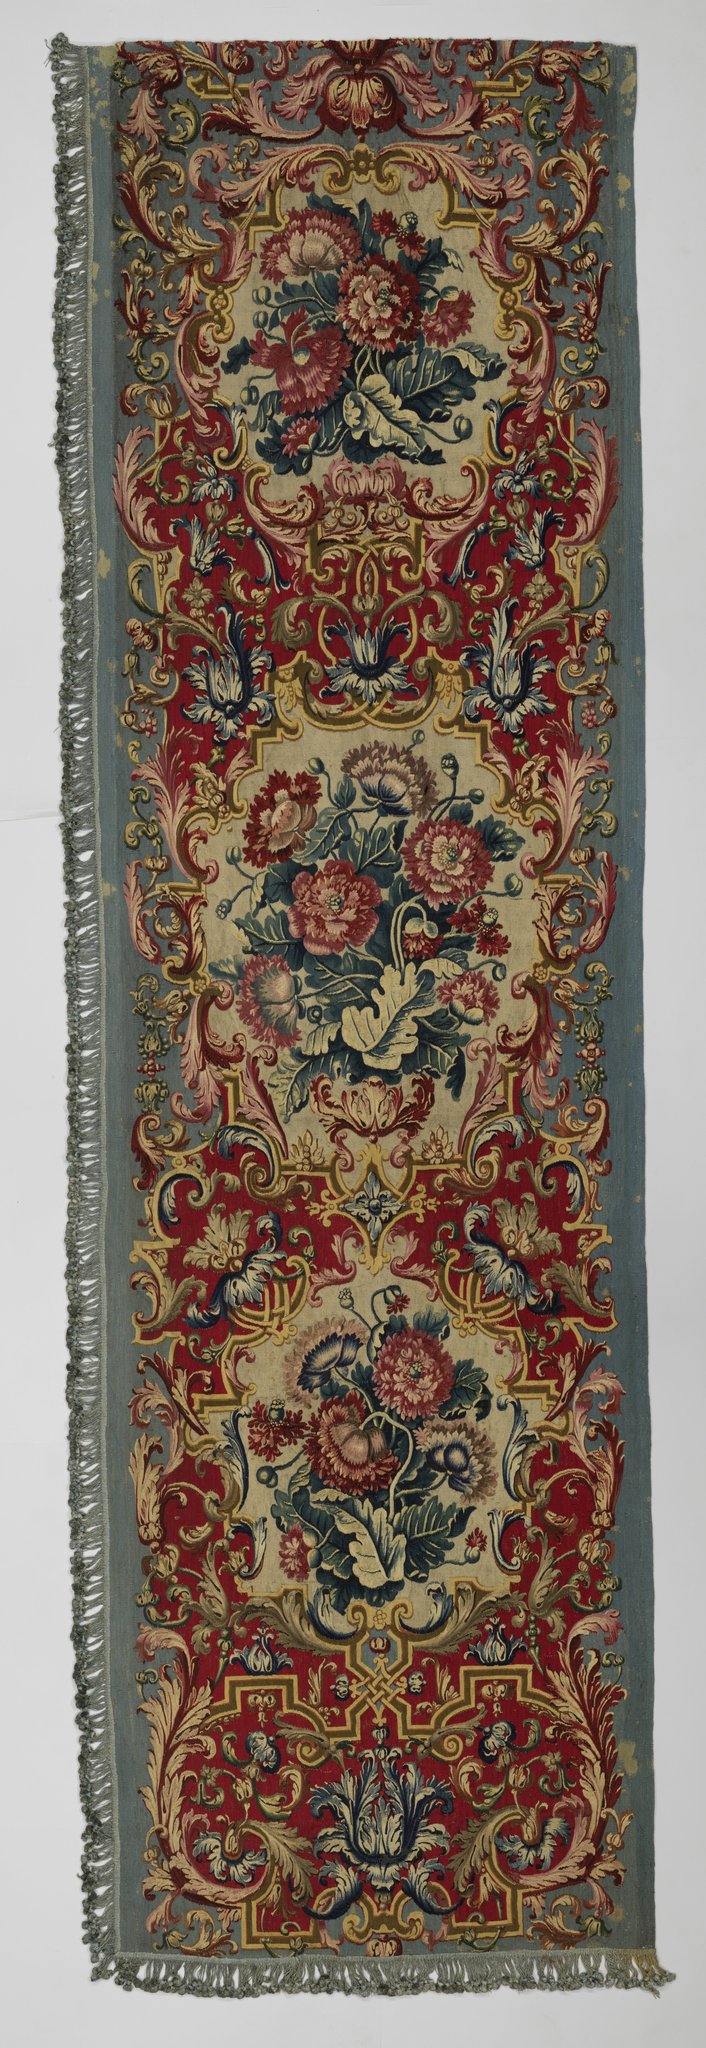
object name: cantonnière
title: Zijstuk van een cantonnière voor een bed of raamomlijsting met een bloemenpatroon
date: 1700-1725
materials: silk, wool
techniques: tapestry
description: Zijstuk van een cantonnière, versierd met dubbele klaprozen binnen een omlijsting van rolwerkbanden met voluten en acanthusranken.